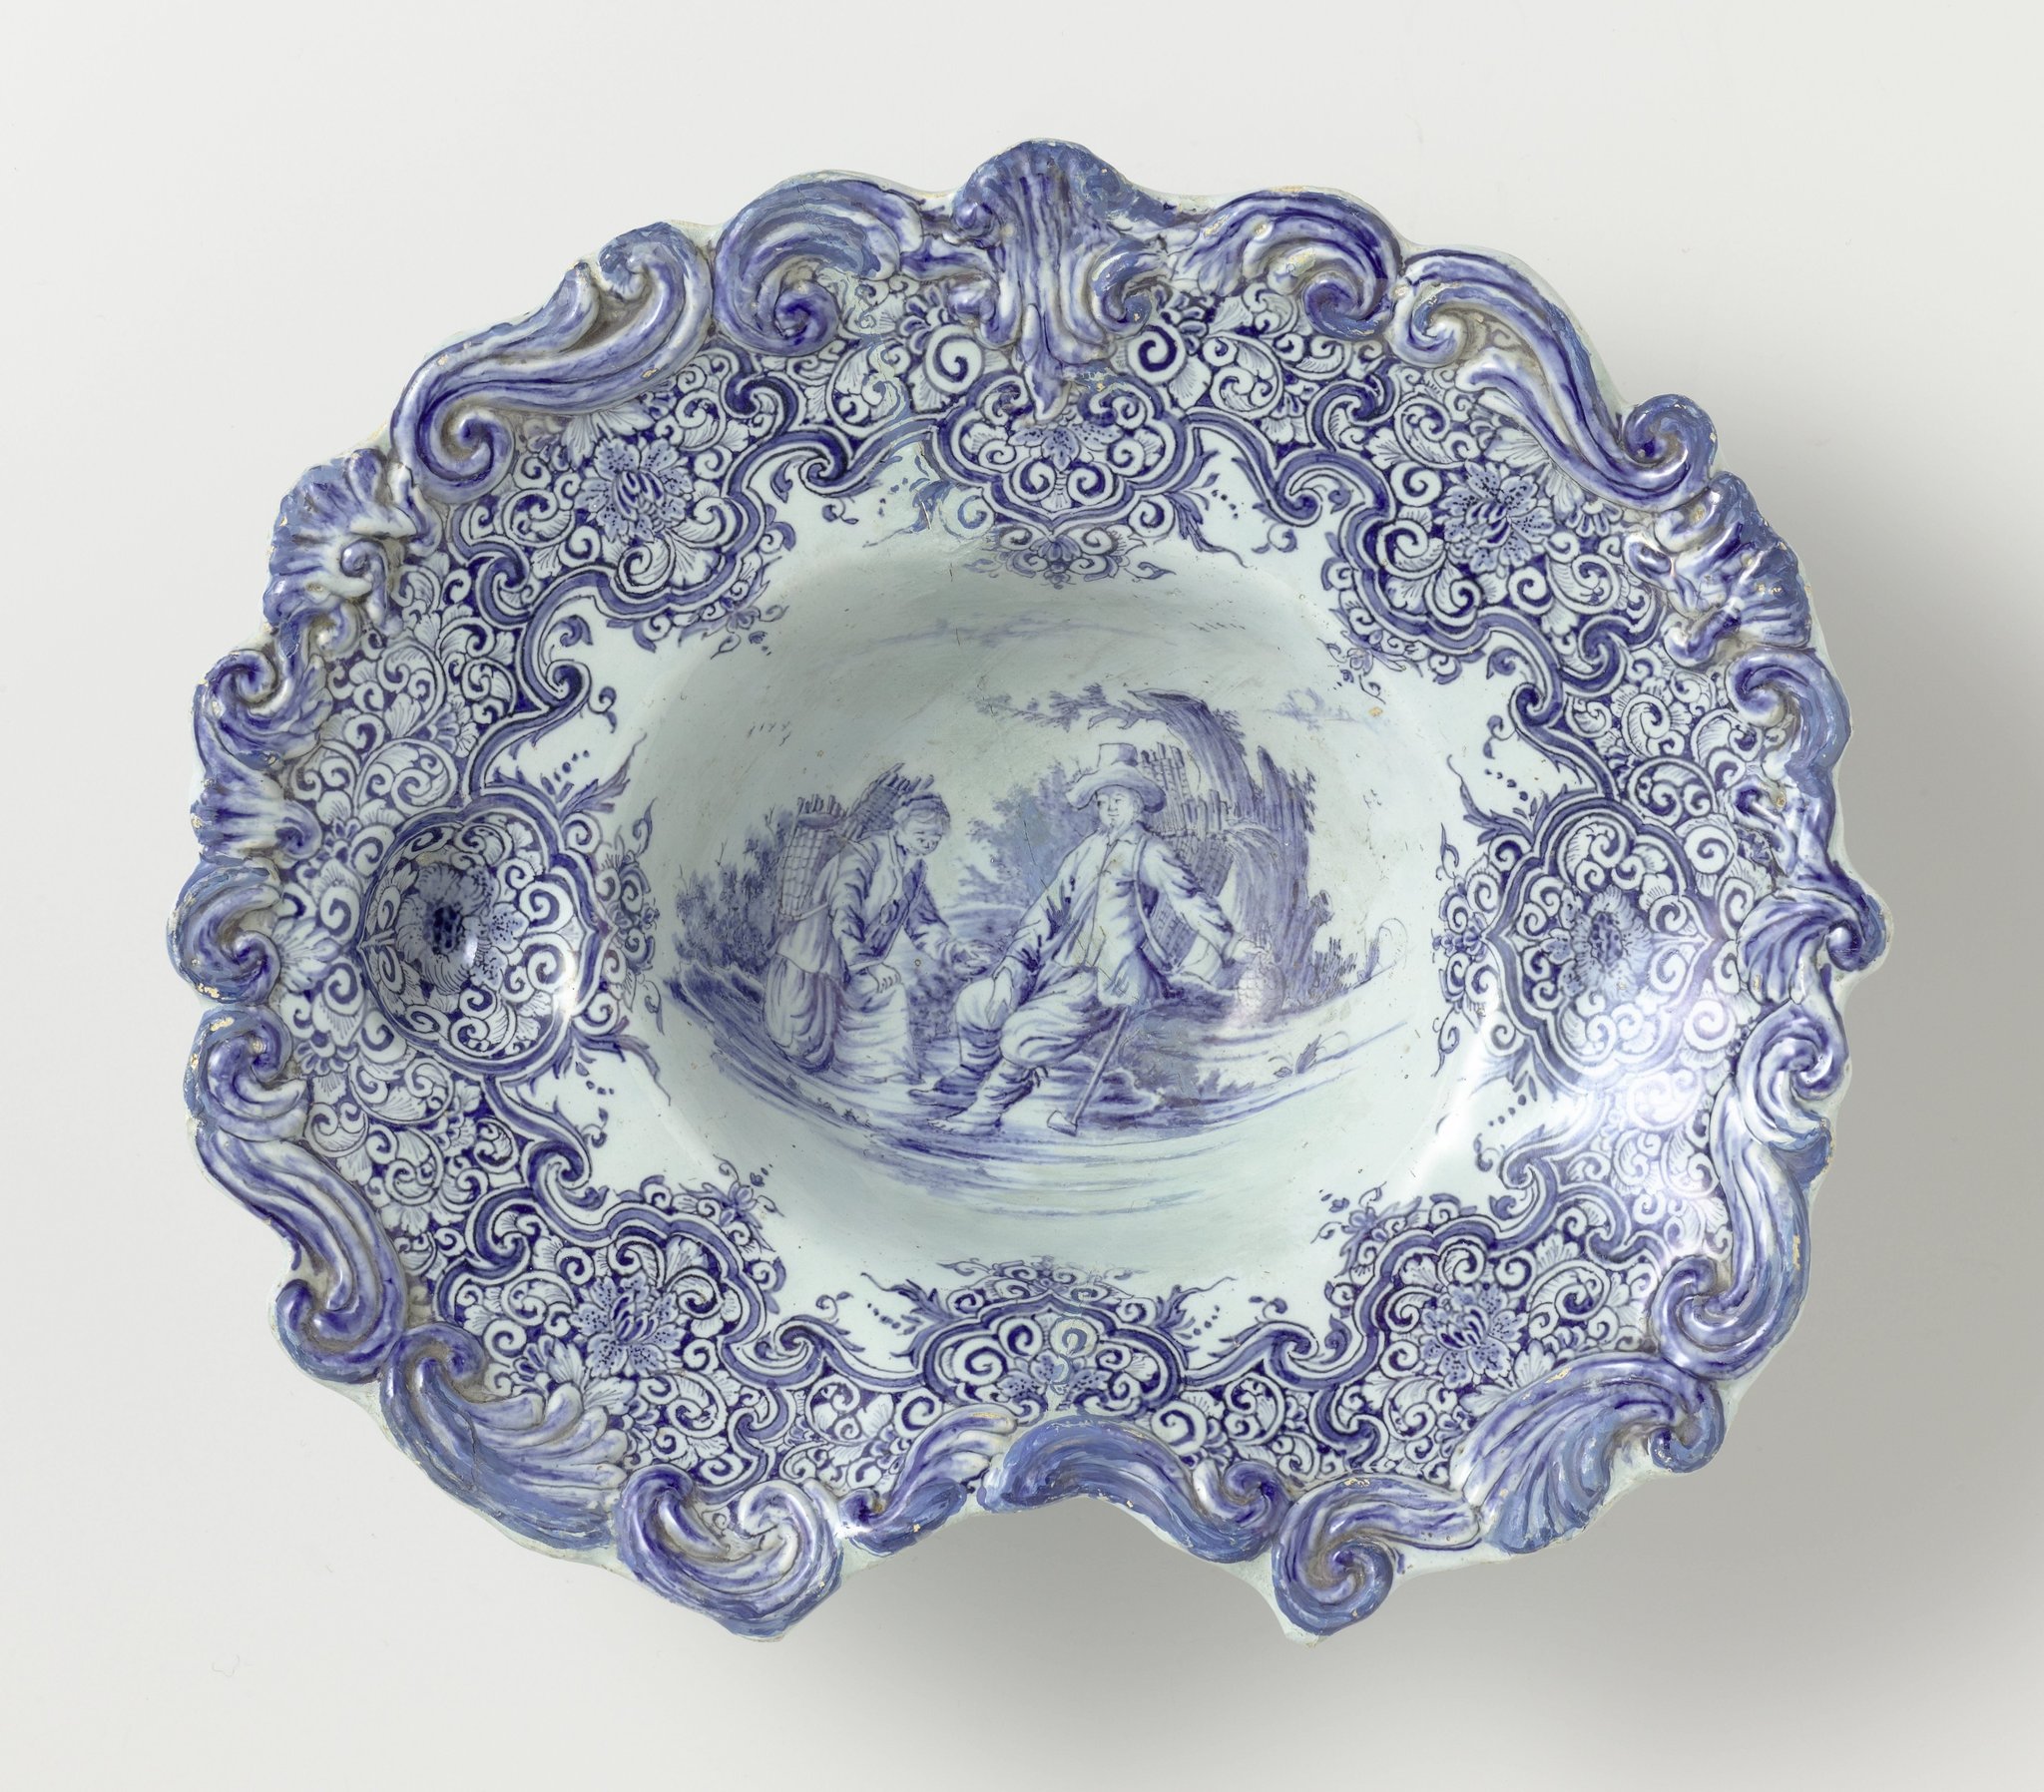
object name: shaving basin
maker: Anonymous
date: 1750-1780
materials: earthenware, glaze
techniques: painted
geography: delft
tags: woodgathering, woodgatherer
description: Scheerbekken van blauw beschilderde faïence met voorstelling van twee houthakkers; langs de rand een lambrequinmotief in reliëf.